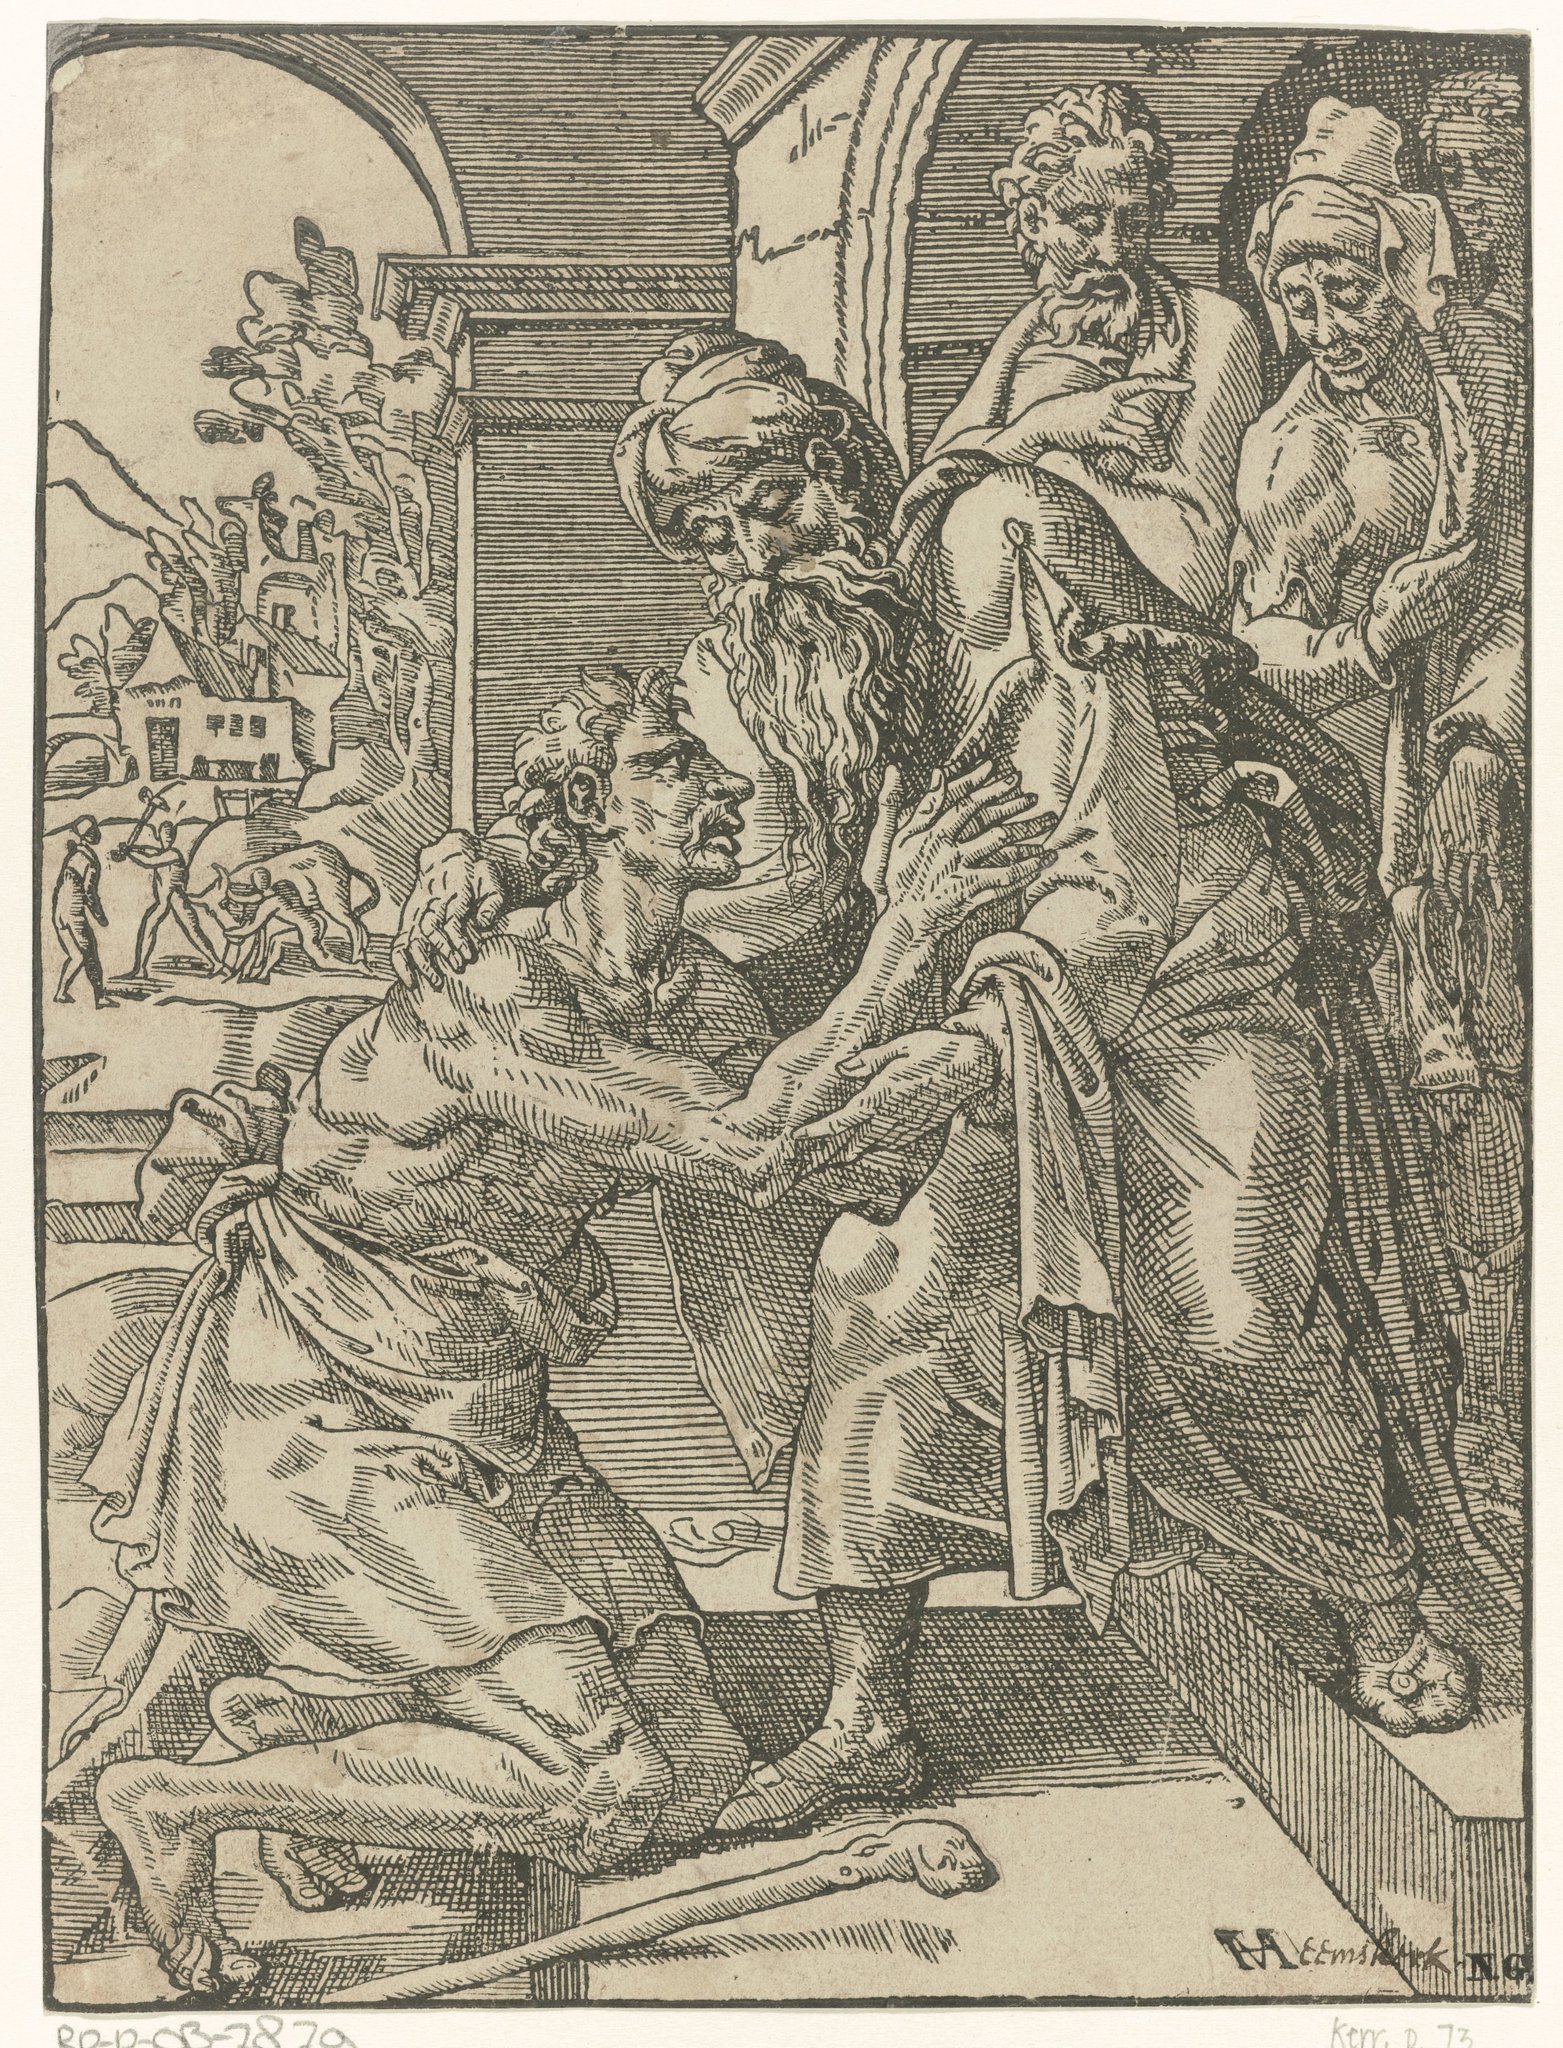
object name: print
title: Gelijkenis van de verloren zoon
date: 1548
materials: paper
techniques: woodcut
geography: netherlands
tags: the prodigal son kneels before his father who takes him in his arms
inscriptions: collector's mark: Lugt 1967, collector's mark: Lugt 2228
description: De verloren zoon keert terug naar huis. Hij wordt daar opgewacht door zijn vader, die hem hartelijk verwelkomt. Op de achtergrond wordt een kalf geslacht voor een feestmaal om de terugkeer van de zoon te vieren.